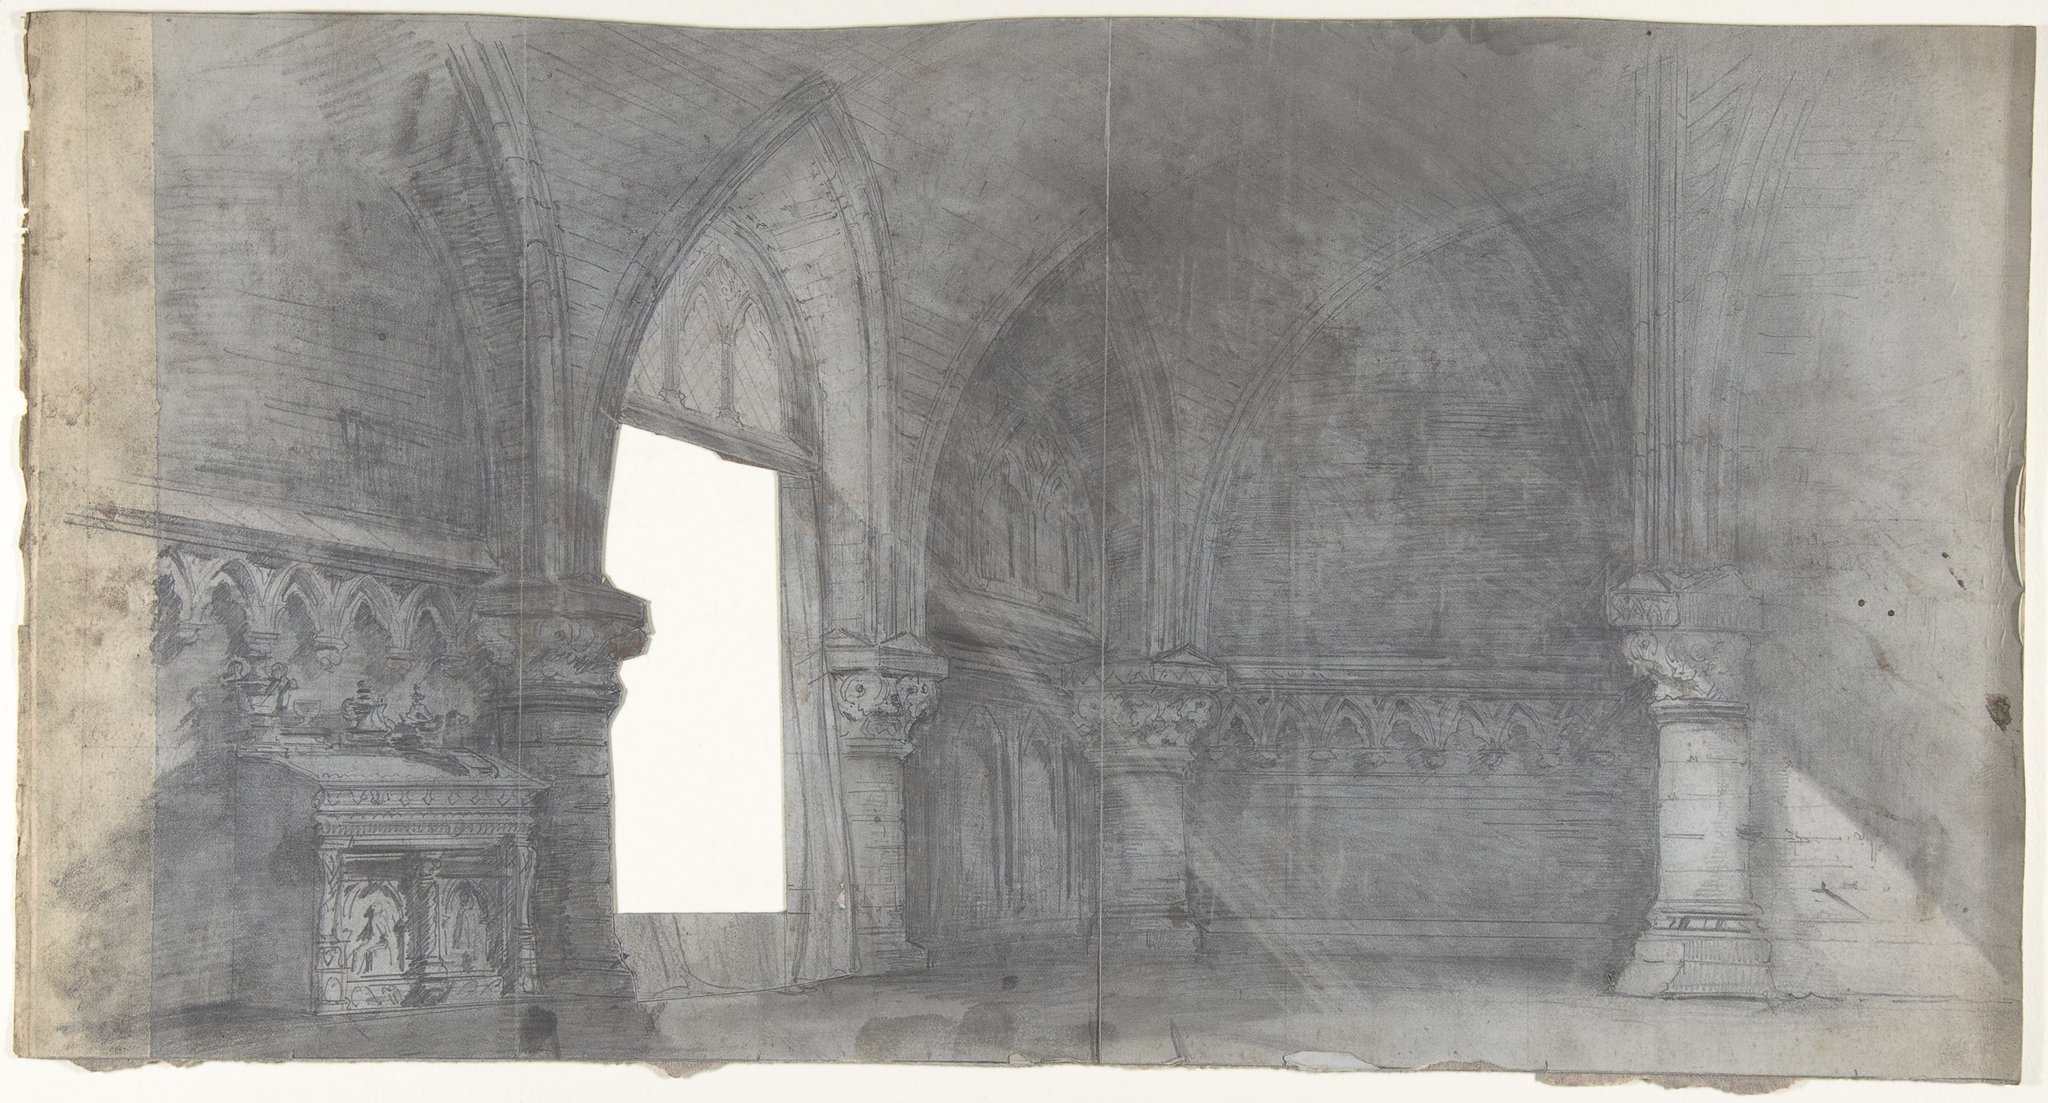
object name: drawing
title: Design for a Stage Set at the Opéra, Paris: Church Interior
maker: eugène cicéri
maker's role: artist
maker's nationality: french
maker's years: 1813-1890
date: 1830-1890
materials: graphite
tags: interiors,churches,stage design